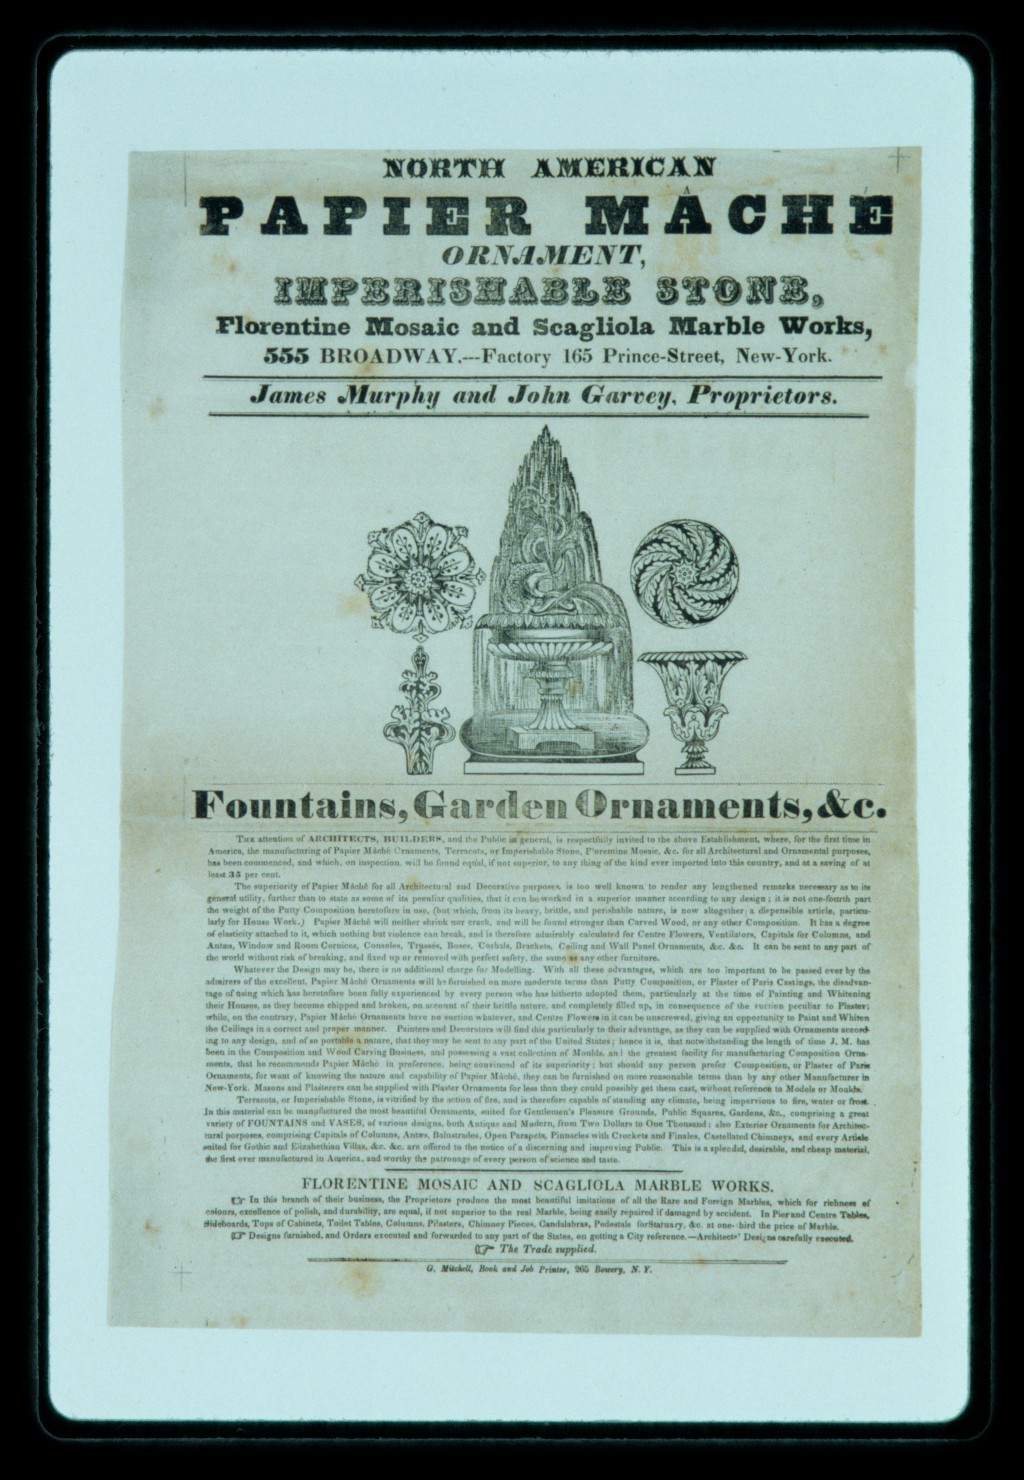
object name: print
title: North American Papier Mâché Ornament Imperishable Stone, Florentine Mosaic and Scagliola Marble Works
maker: james murphy and john garvey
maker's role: author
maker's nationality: american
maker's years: 1800-1900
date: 1801-1900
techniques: engraving